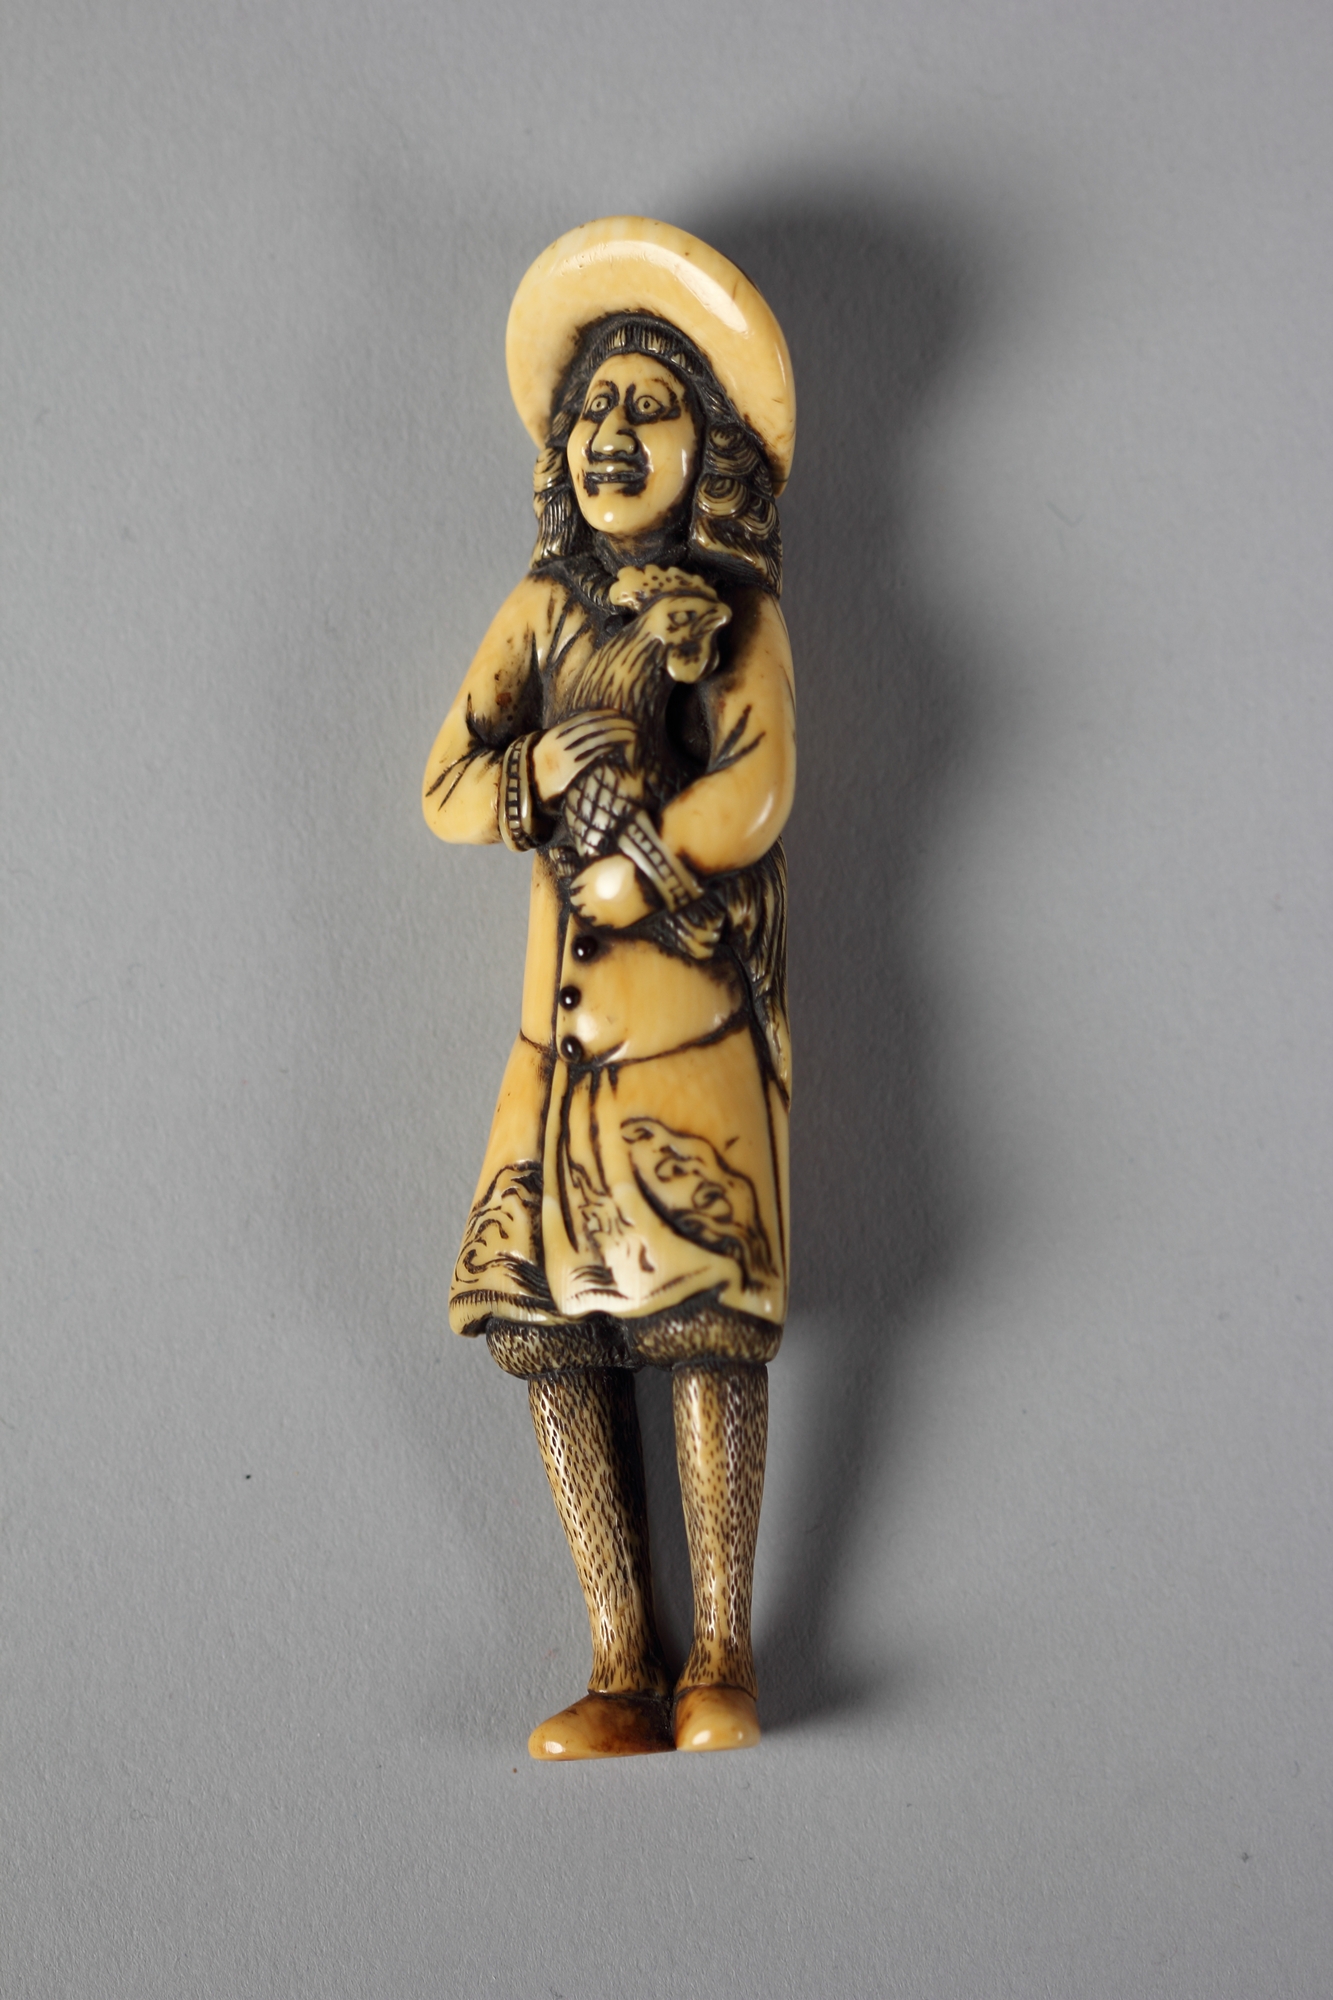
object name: netsuke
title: Netsuke of Dutchman Holding a Cock in His Arms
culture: japanese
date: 1767-1800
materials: ivory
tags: roosters